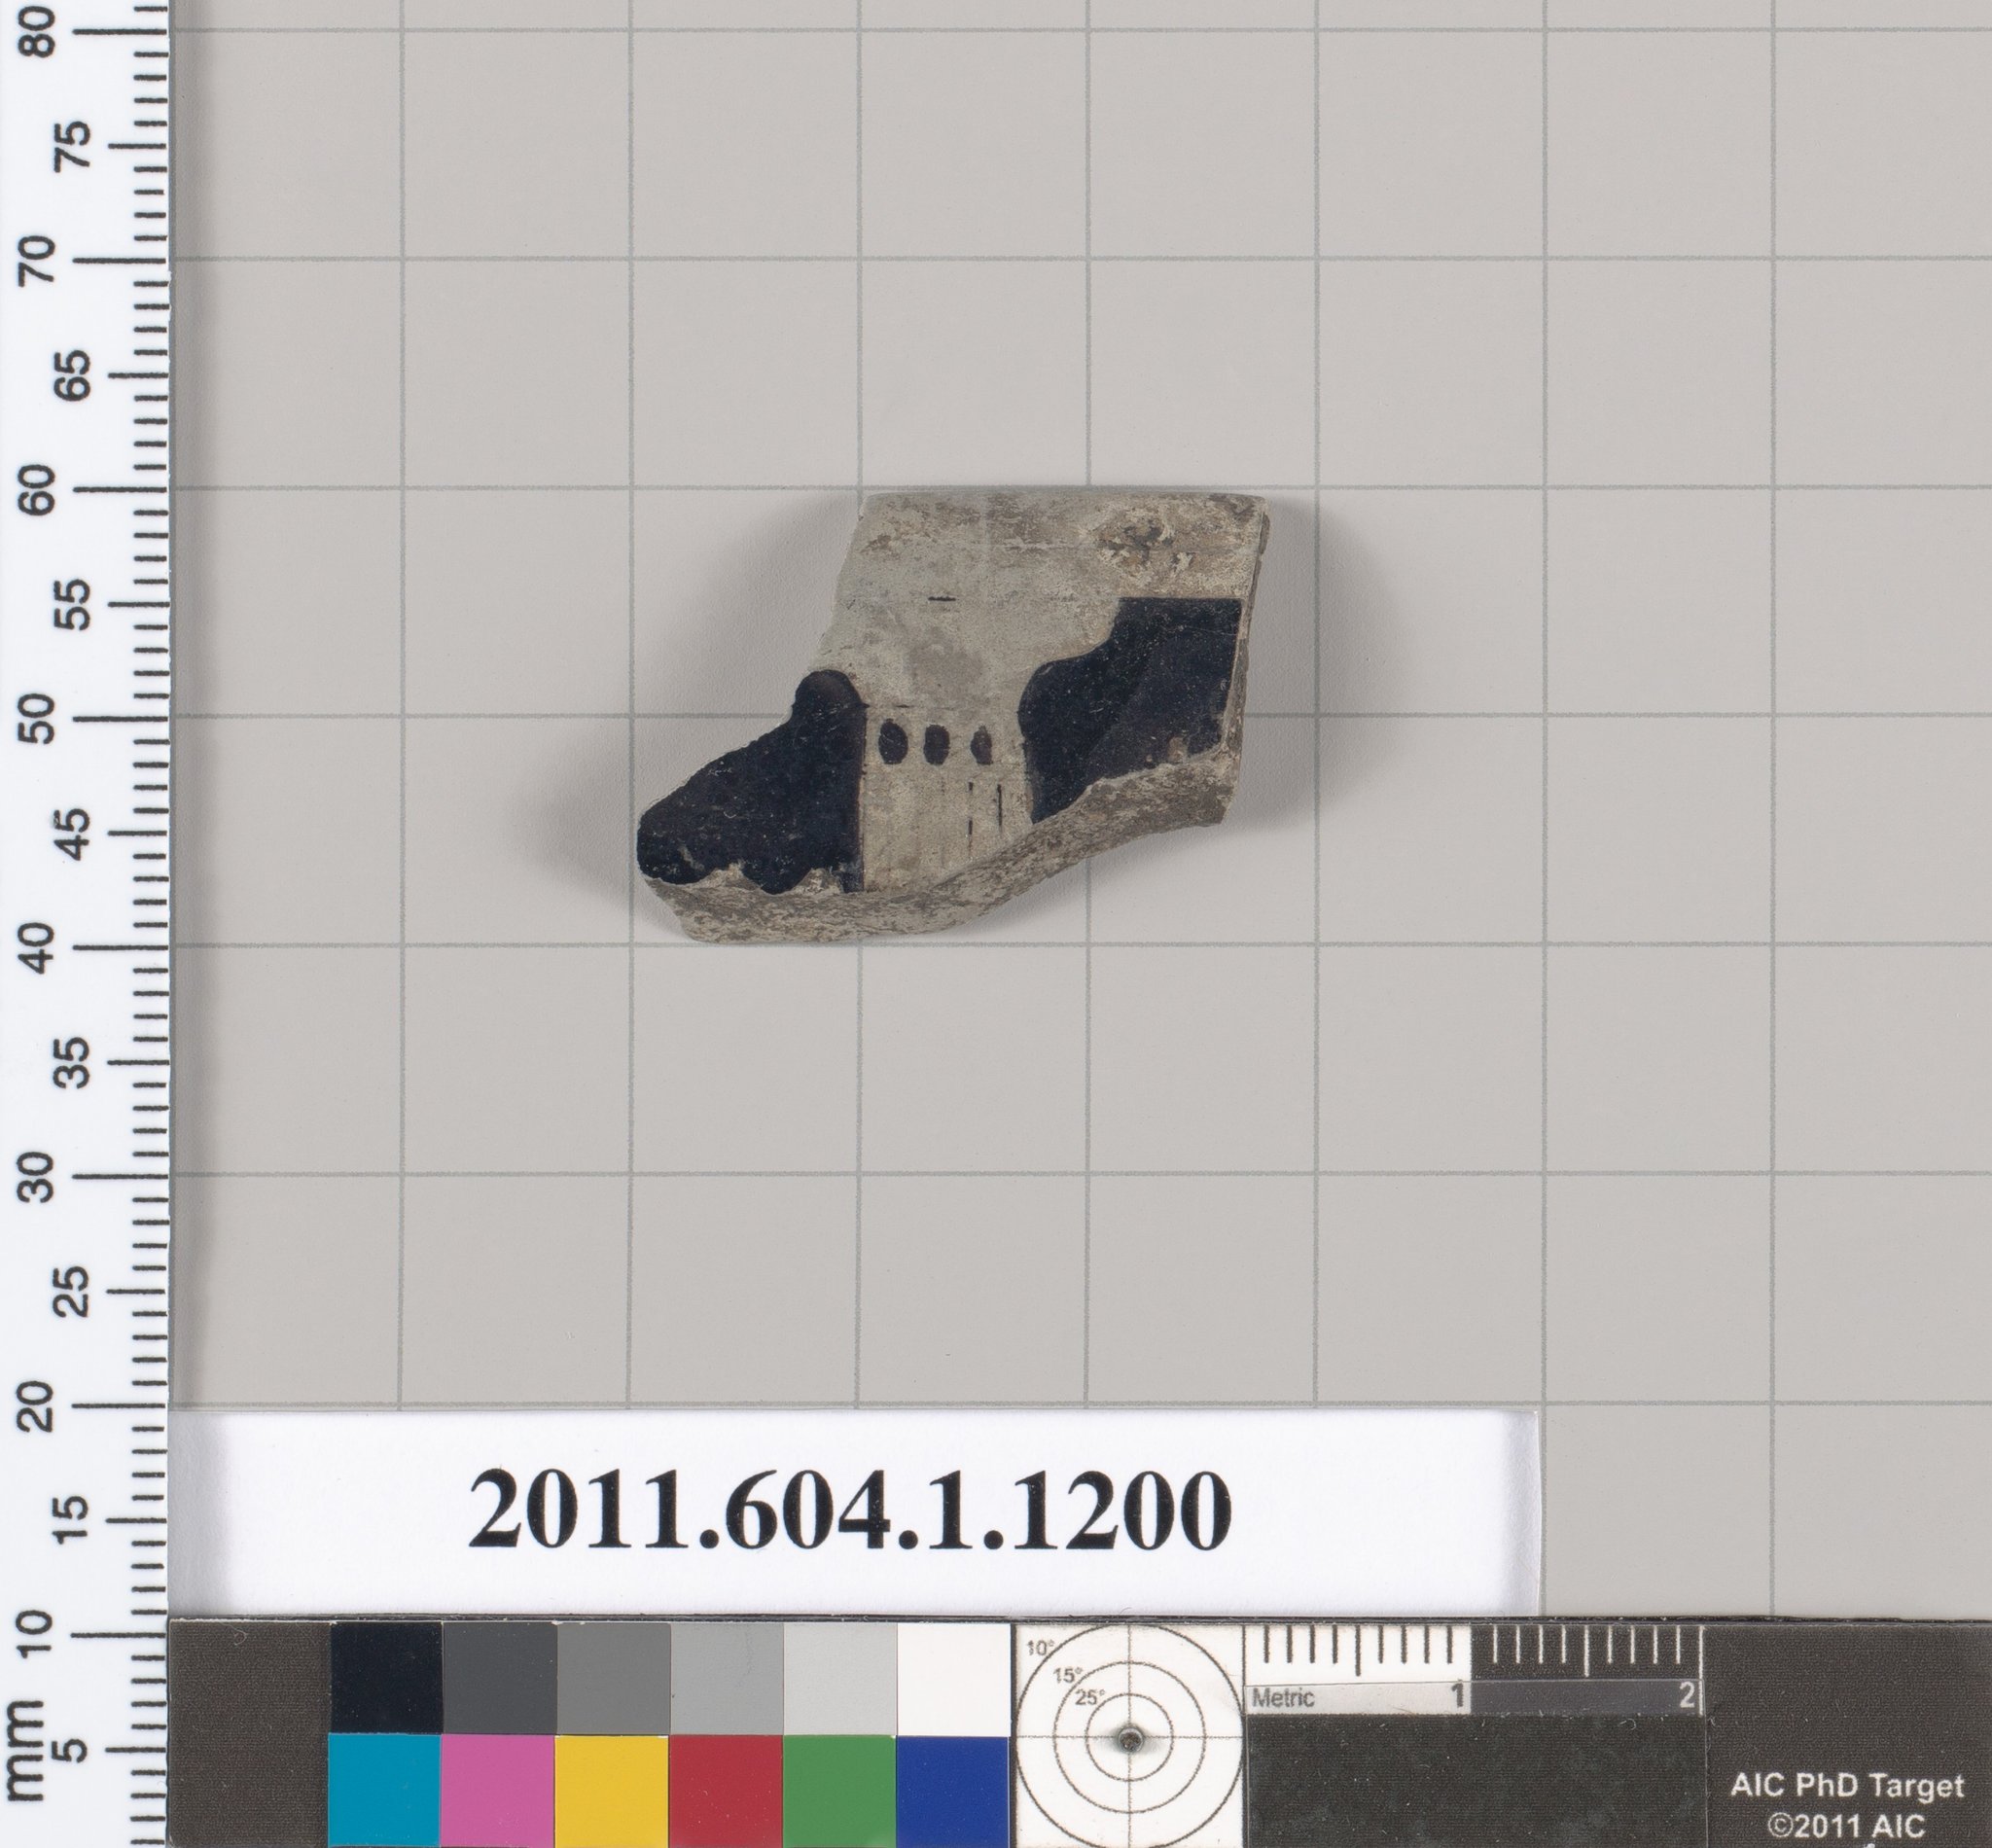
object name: kylix fragment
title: Terracotta rim fragment of a kylix (drinking cup)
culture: greek, attic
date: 475-451 BCE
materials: terracotta